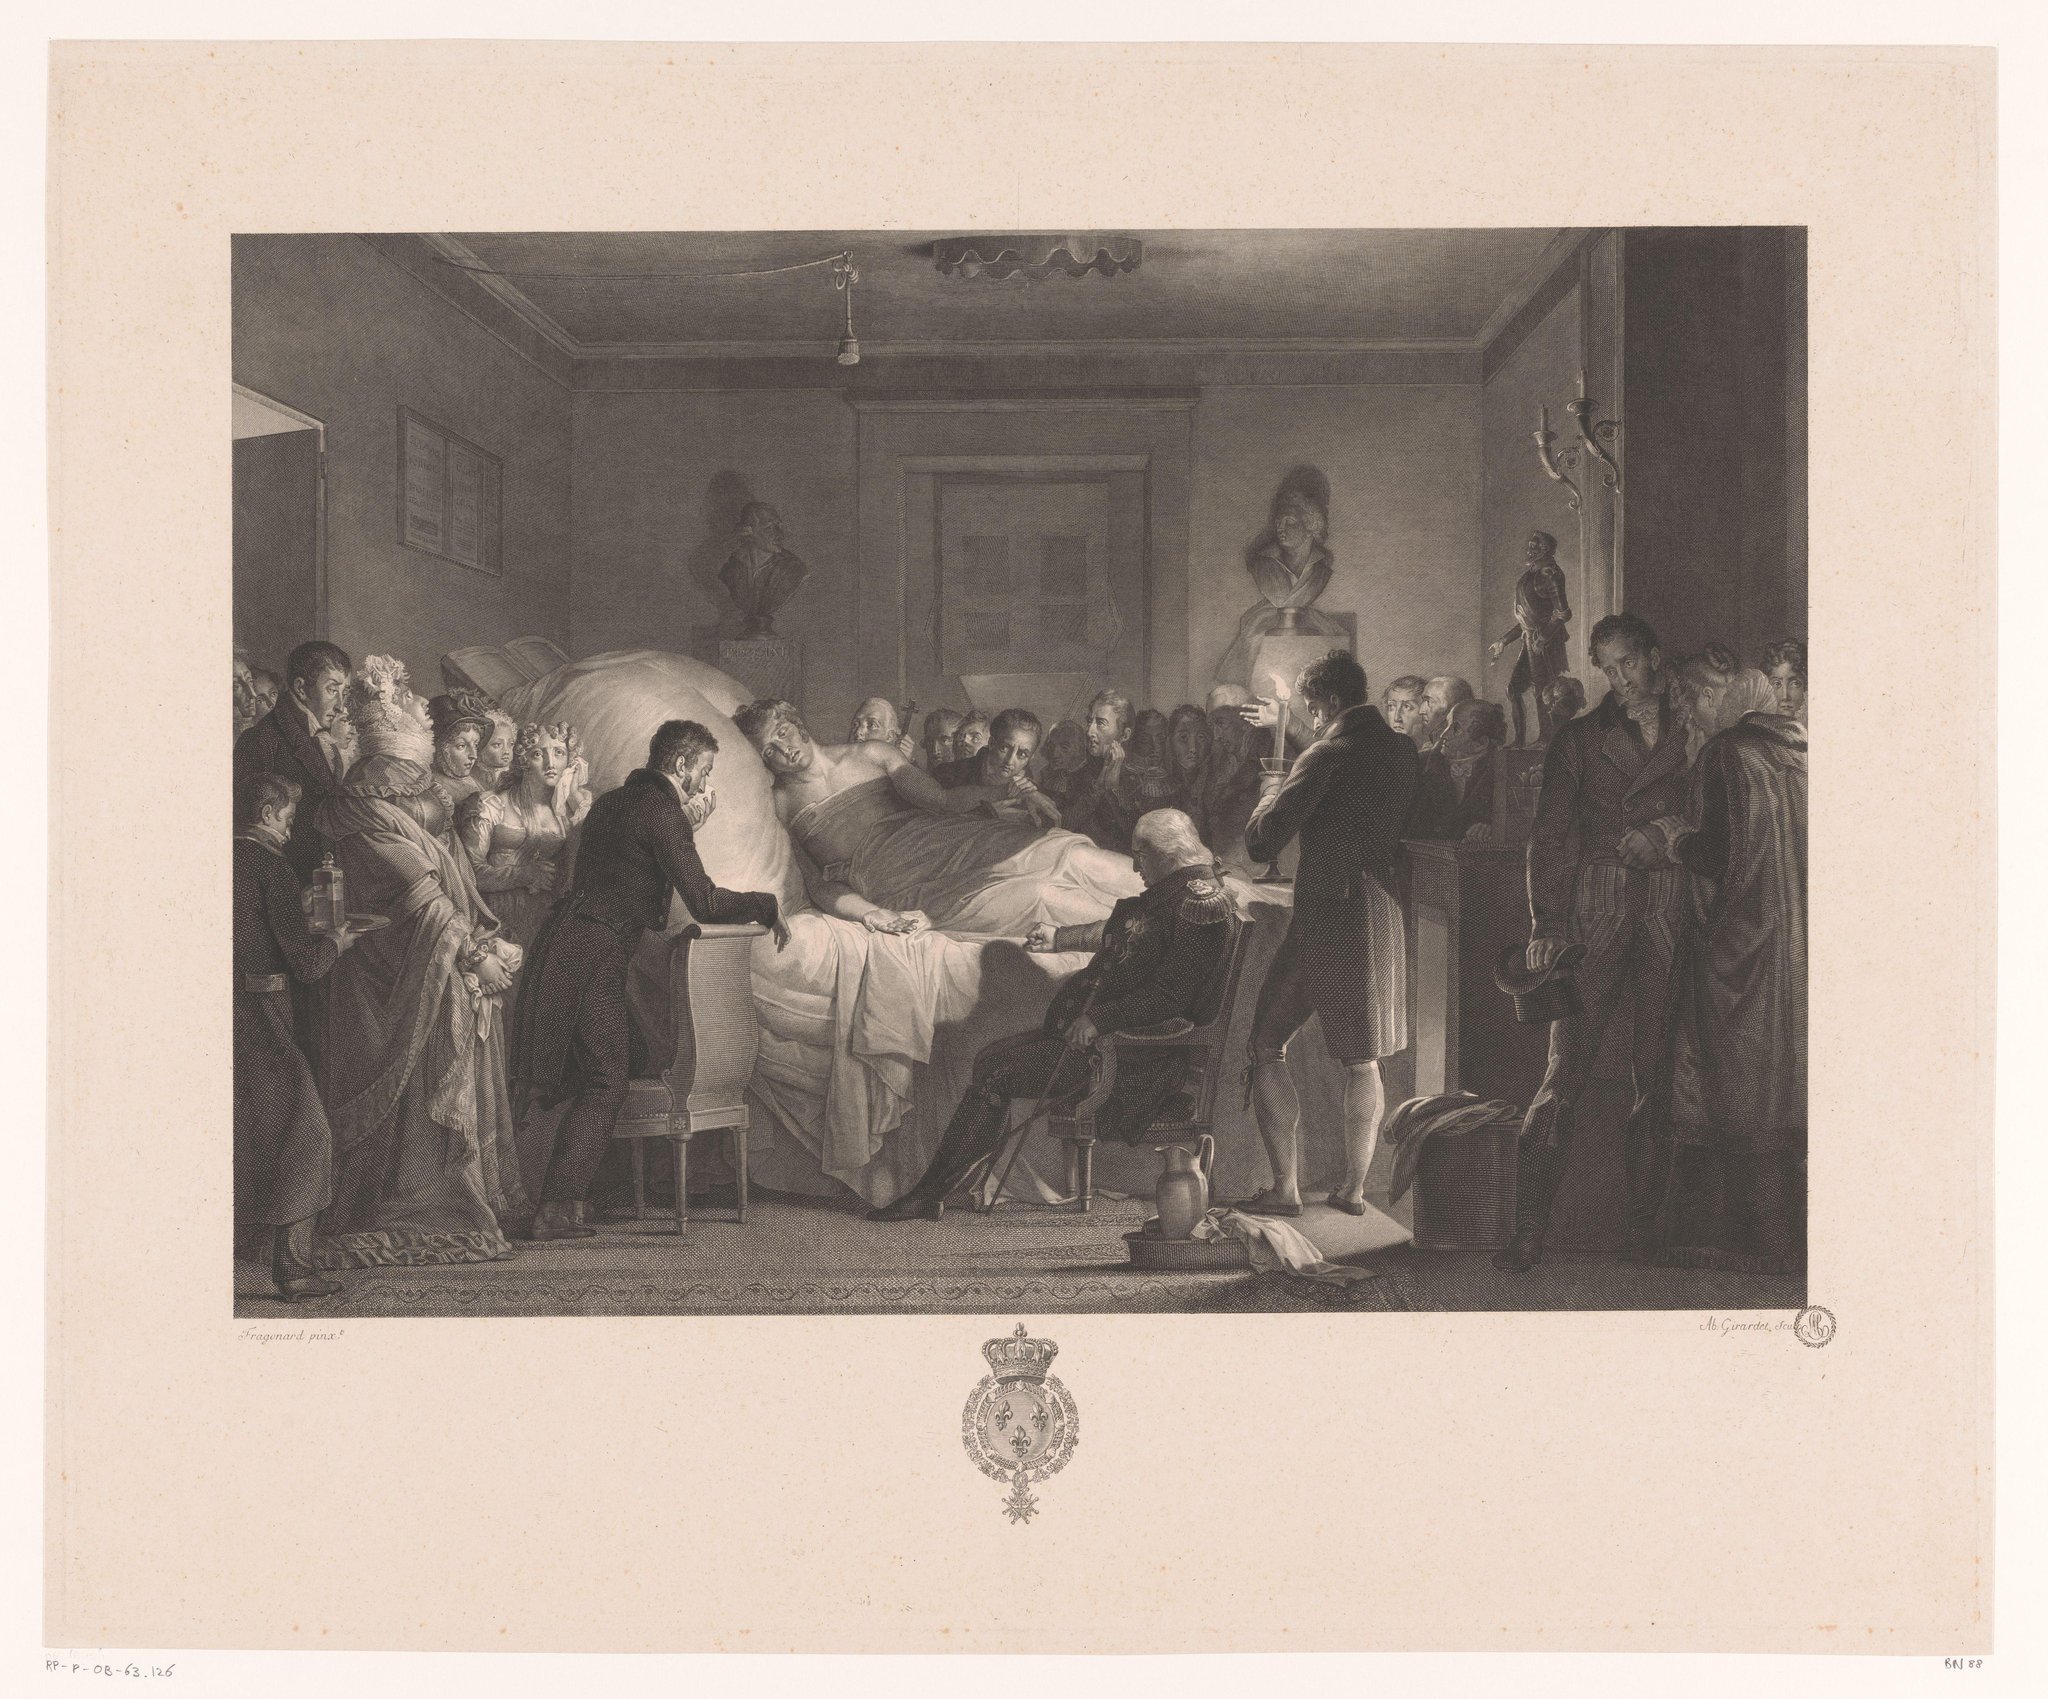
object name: print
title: Derniers moments de S.A.R. Monseigneur le duc de Berry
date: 1823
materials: paper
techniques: engraving, etching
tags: paris, deathbed, historical persons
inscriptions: collector's mark: Lugt 5062, collector's mark: Lugt 12